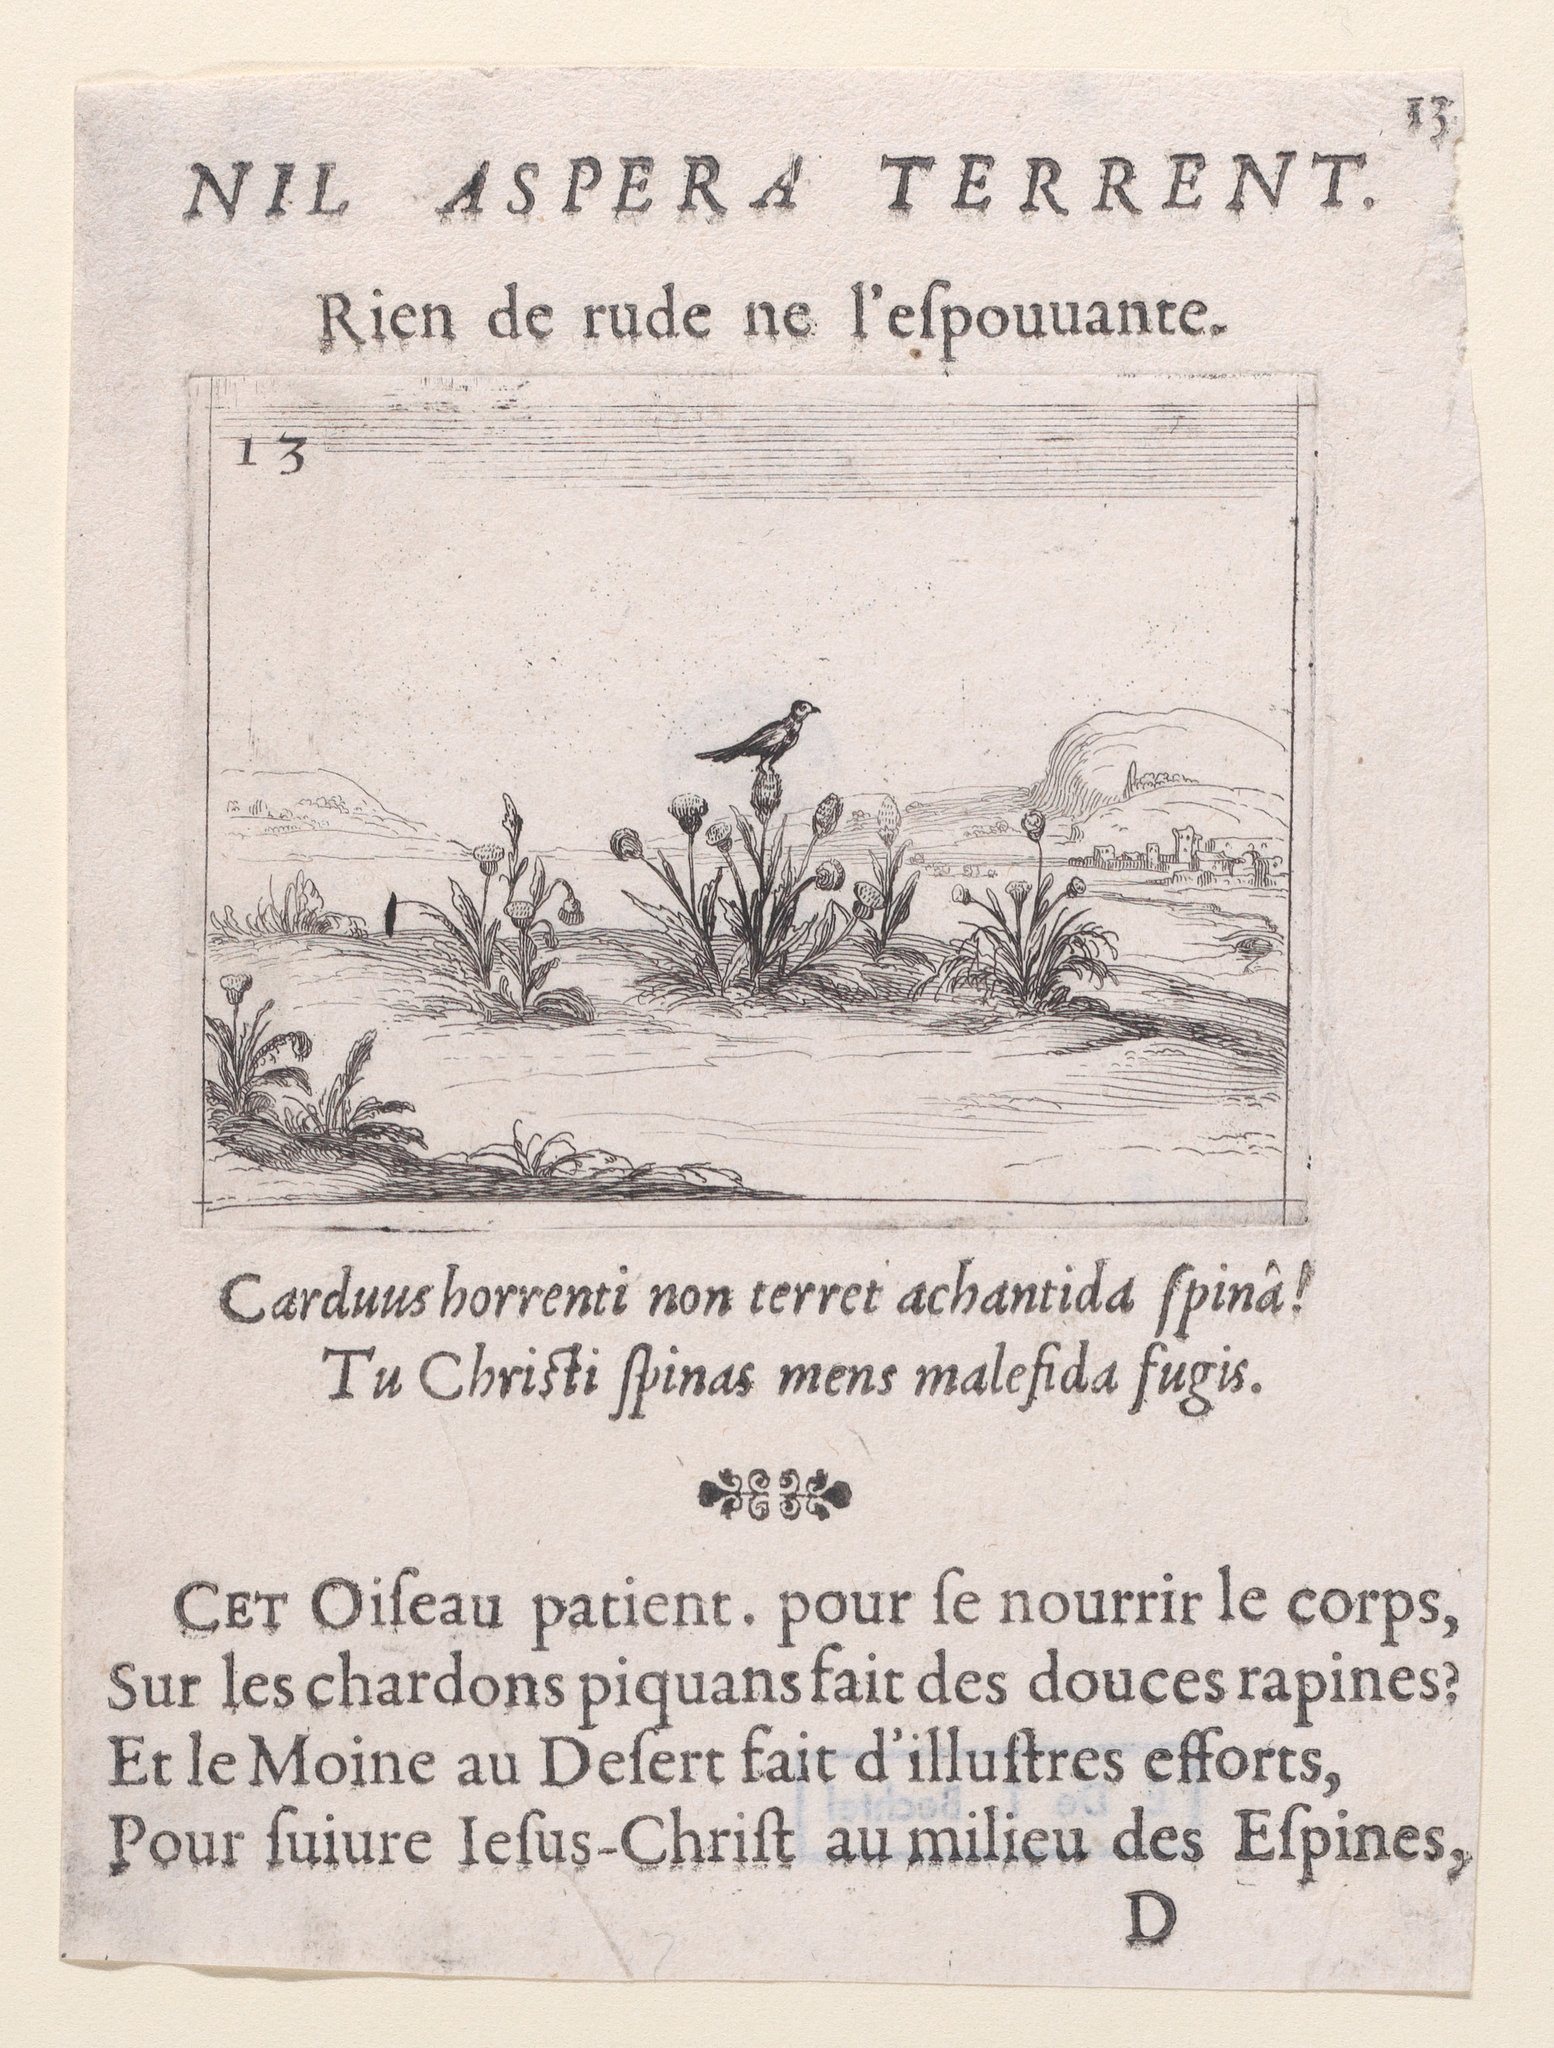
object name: print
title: L'Oiseau Posé sur un Chardon en Fleurs (The Bird Standing on Thistle Flower), plate 13 from "Lux Claustri ou La Lumière du Cloitre" (The Light of the Cloisters)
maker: jacques callot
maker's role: artist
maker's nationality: french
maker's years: 1592-1635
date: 1625-1631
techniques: etching, letterpress